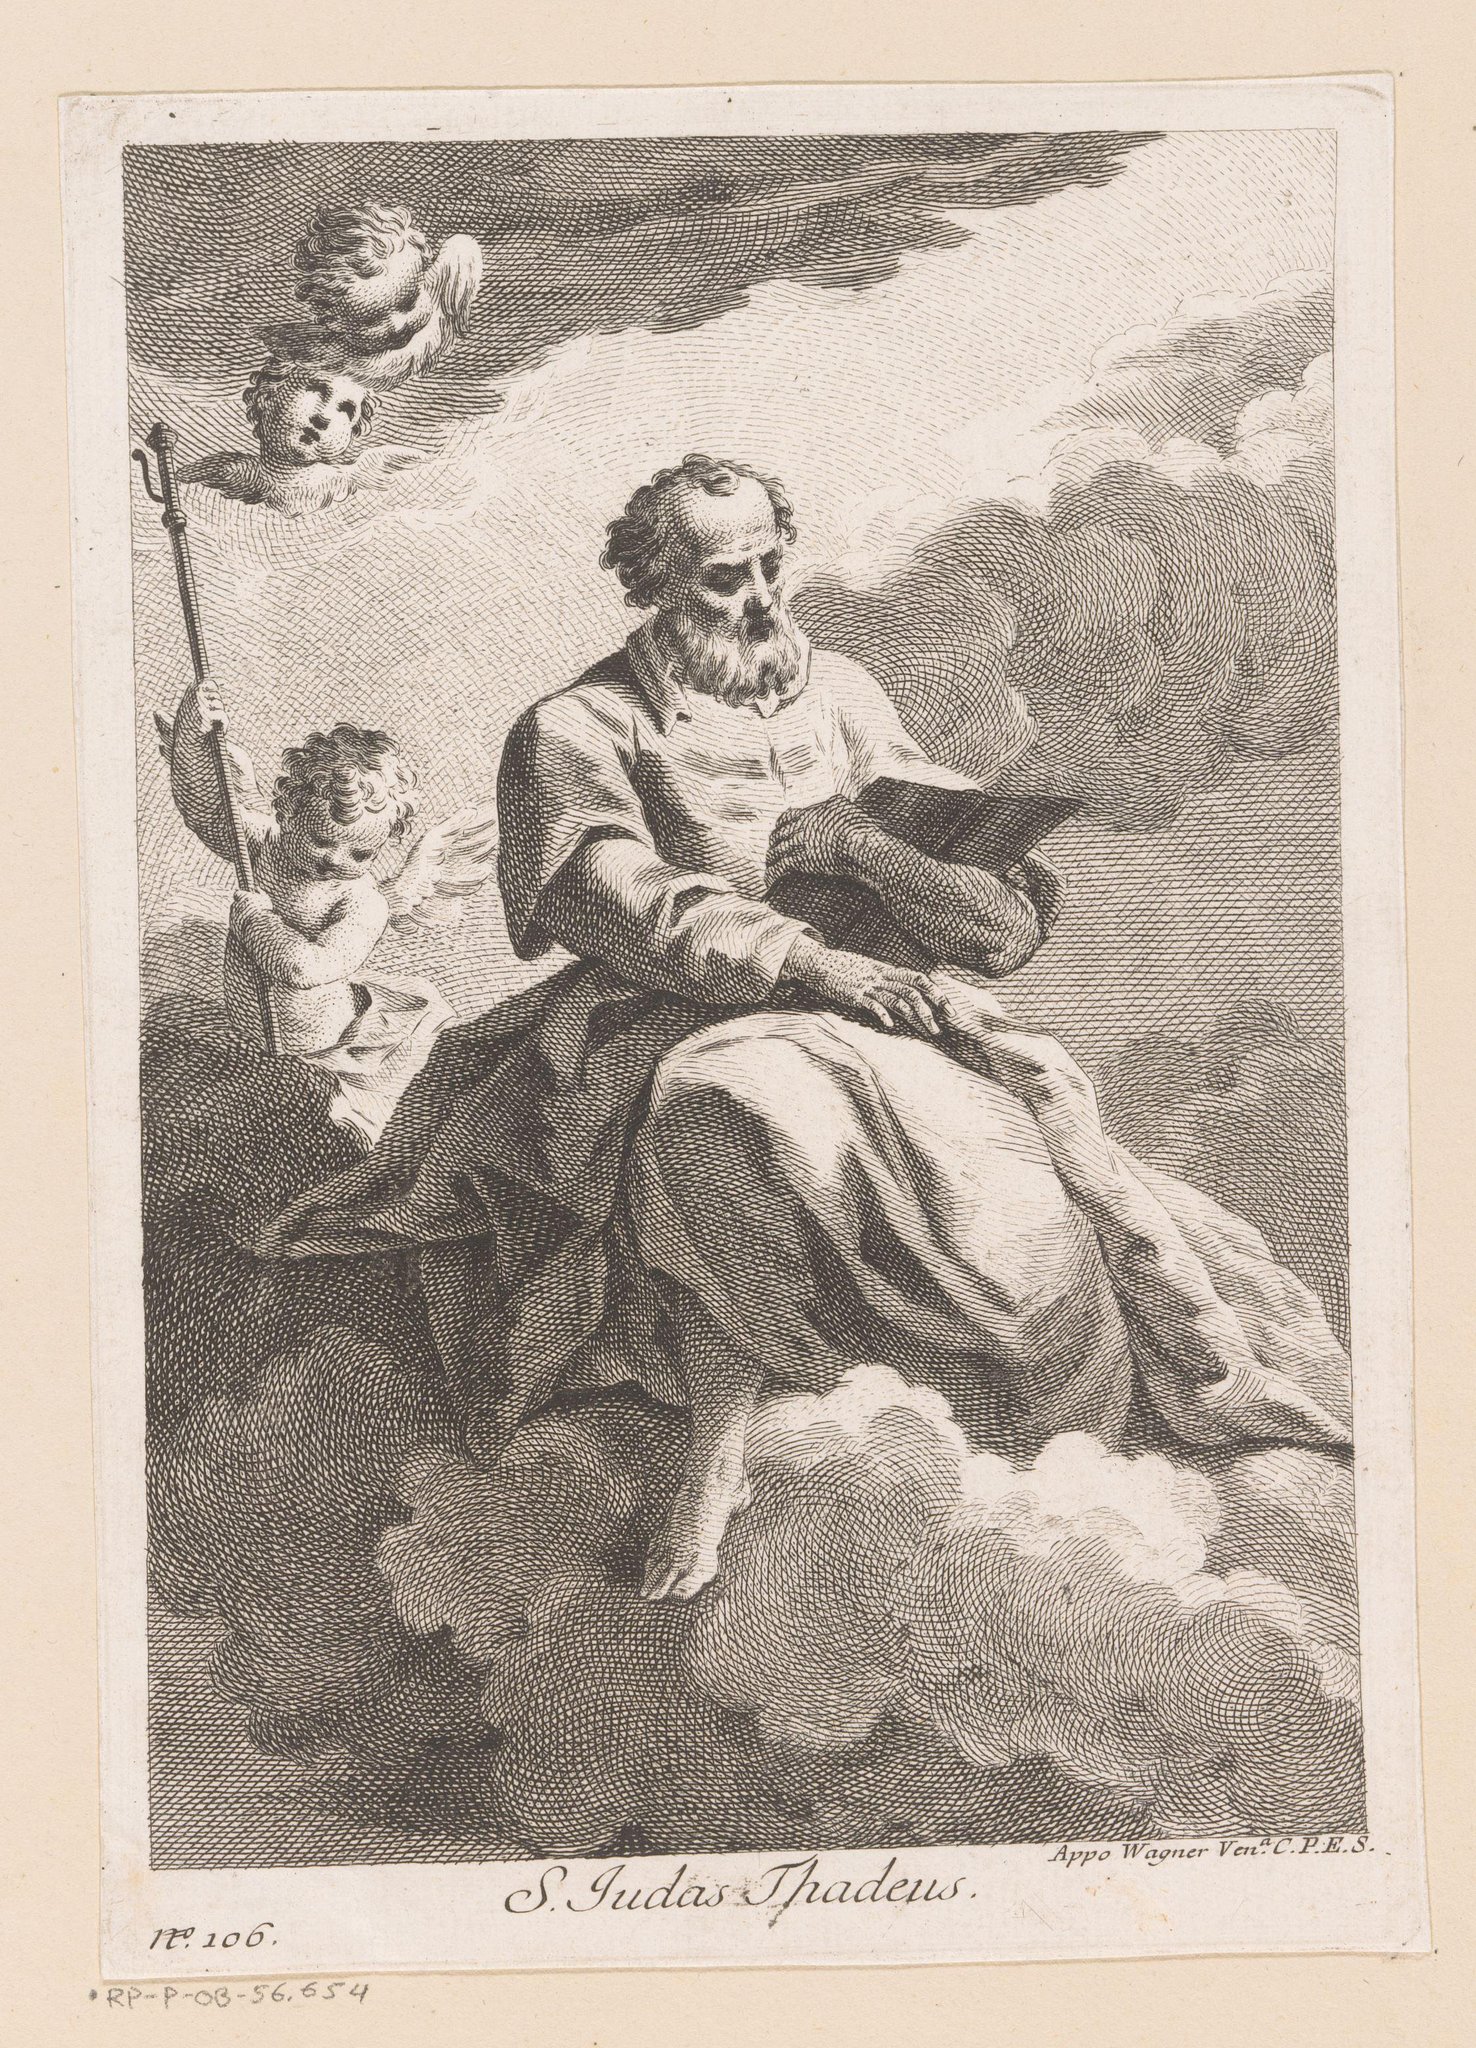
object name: print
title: Heilige Judas Taddeüs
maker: joseph wagner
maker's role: painter, print maker, publisher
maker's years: 1706-1780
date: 1739-1780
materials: paper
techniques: etching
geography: venice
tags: the apostle jude thaddaeus; possible attributes: book, club, halberd, scroll